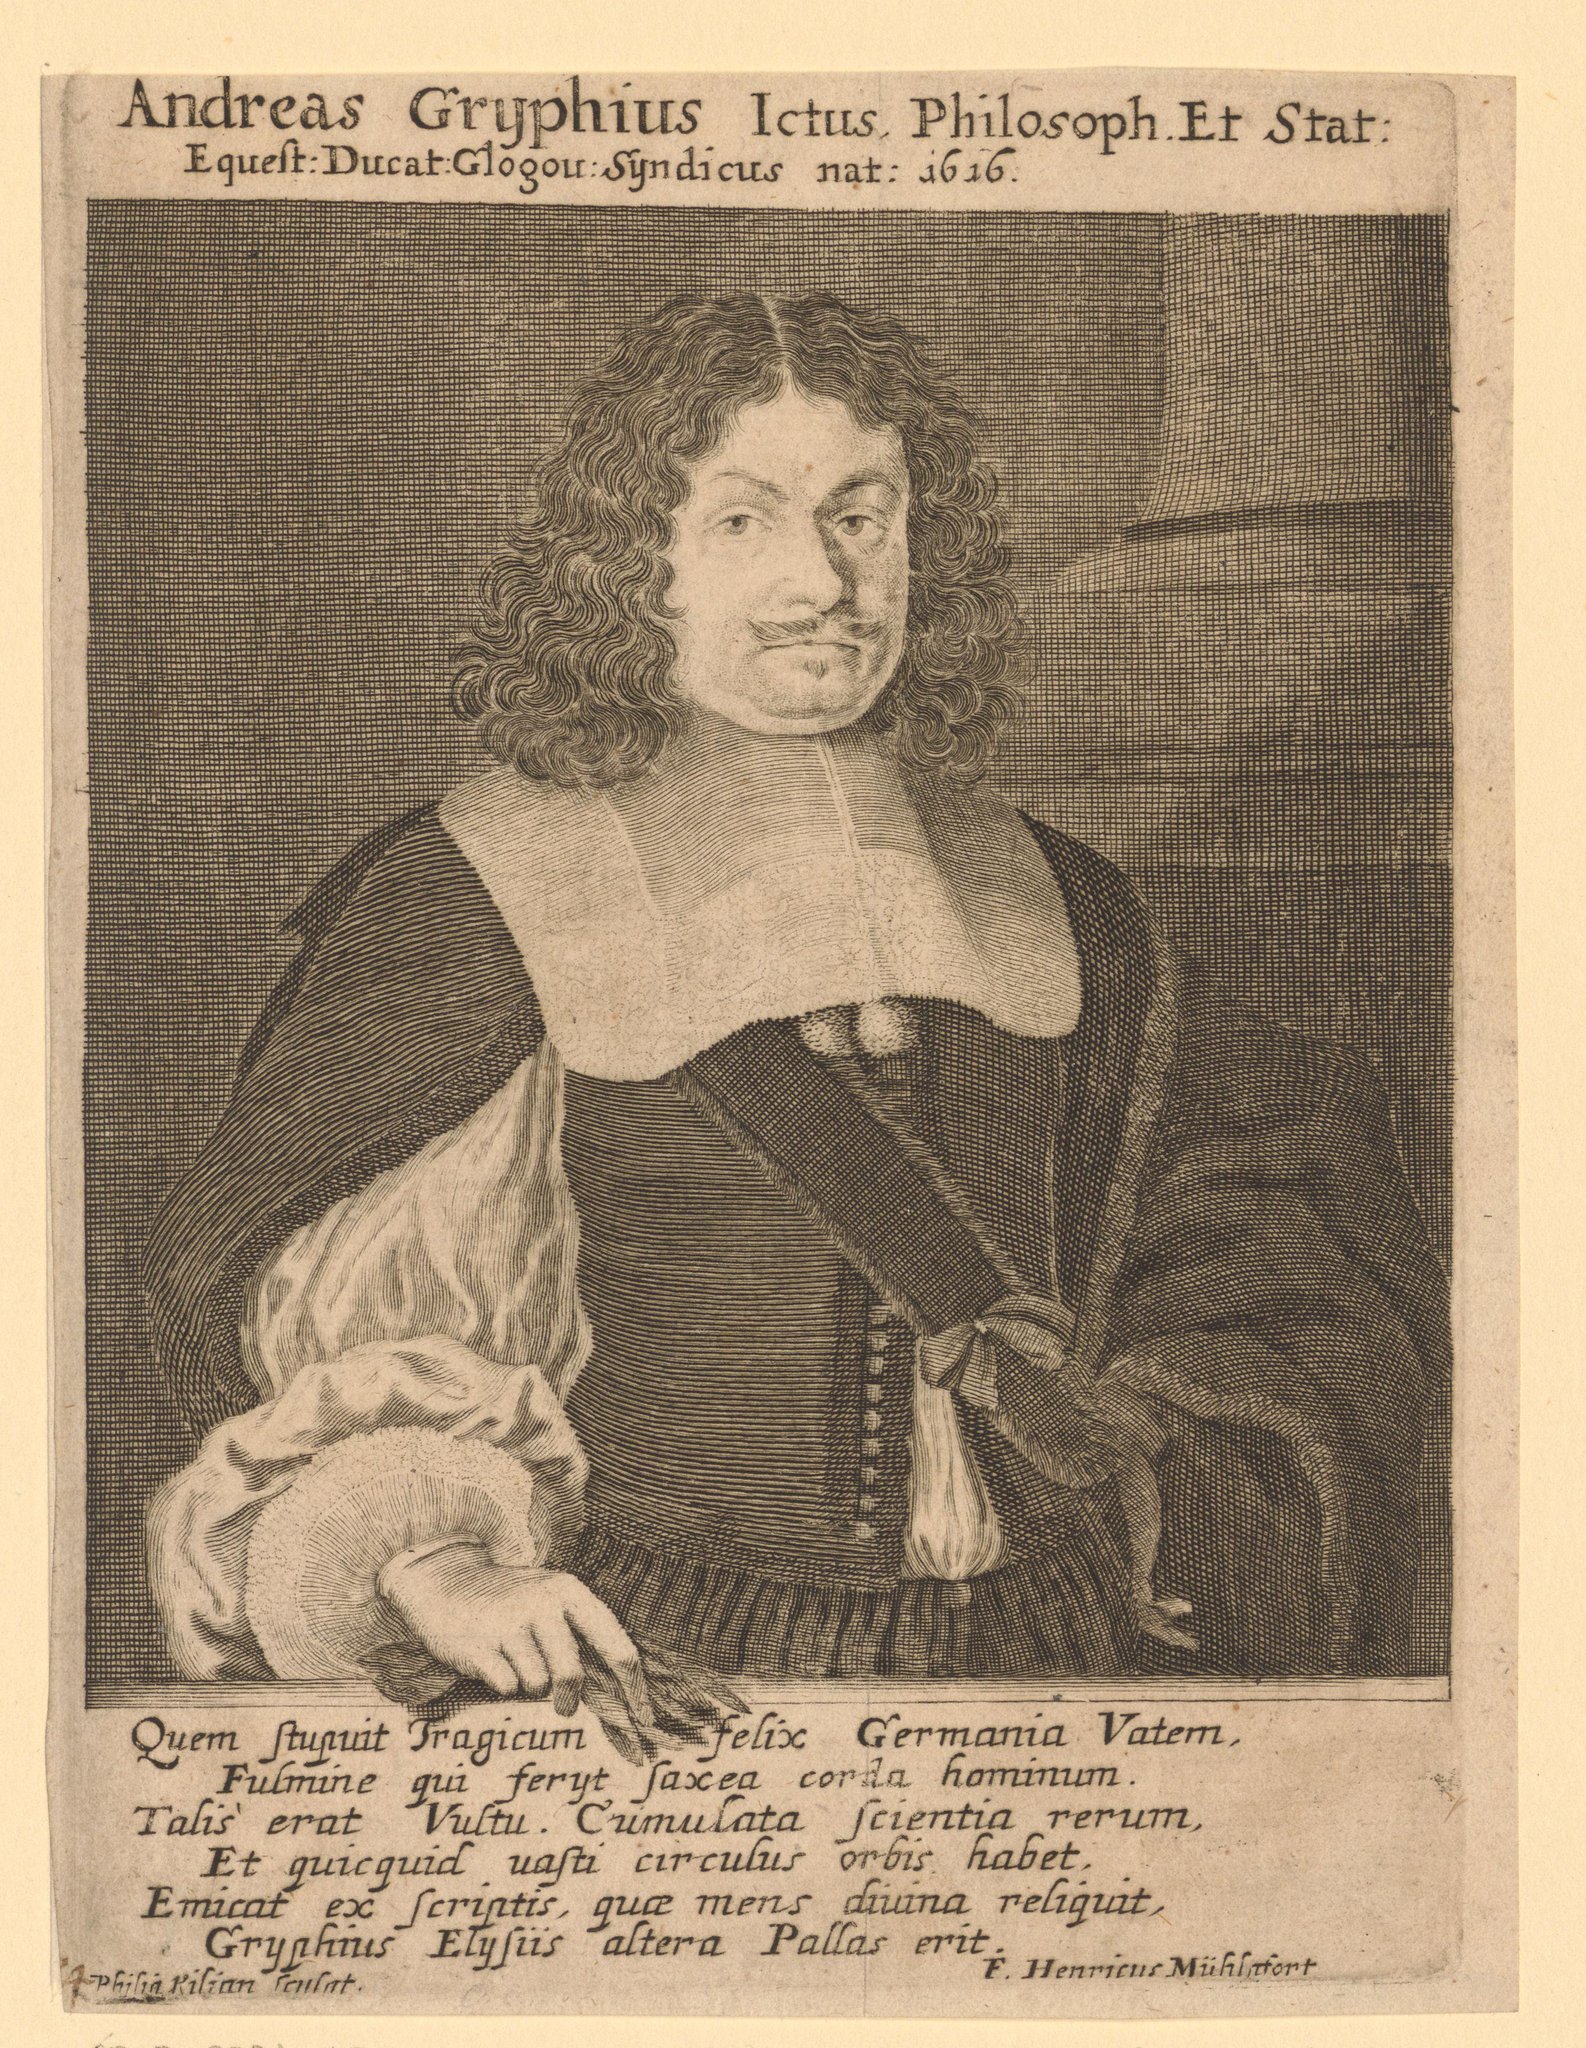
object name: print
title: Portret van Andreas Gryphius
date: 1638-1664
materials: paper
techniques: engraving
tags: historical persons, portrait of a writer, writer, poet, author